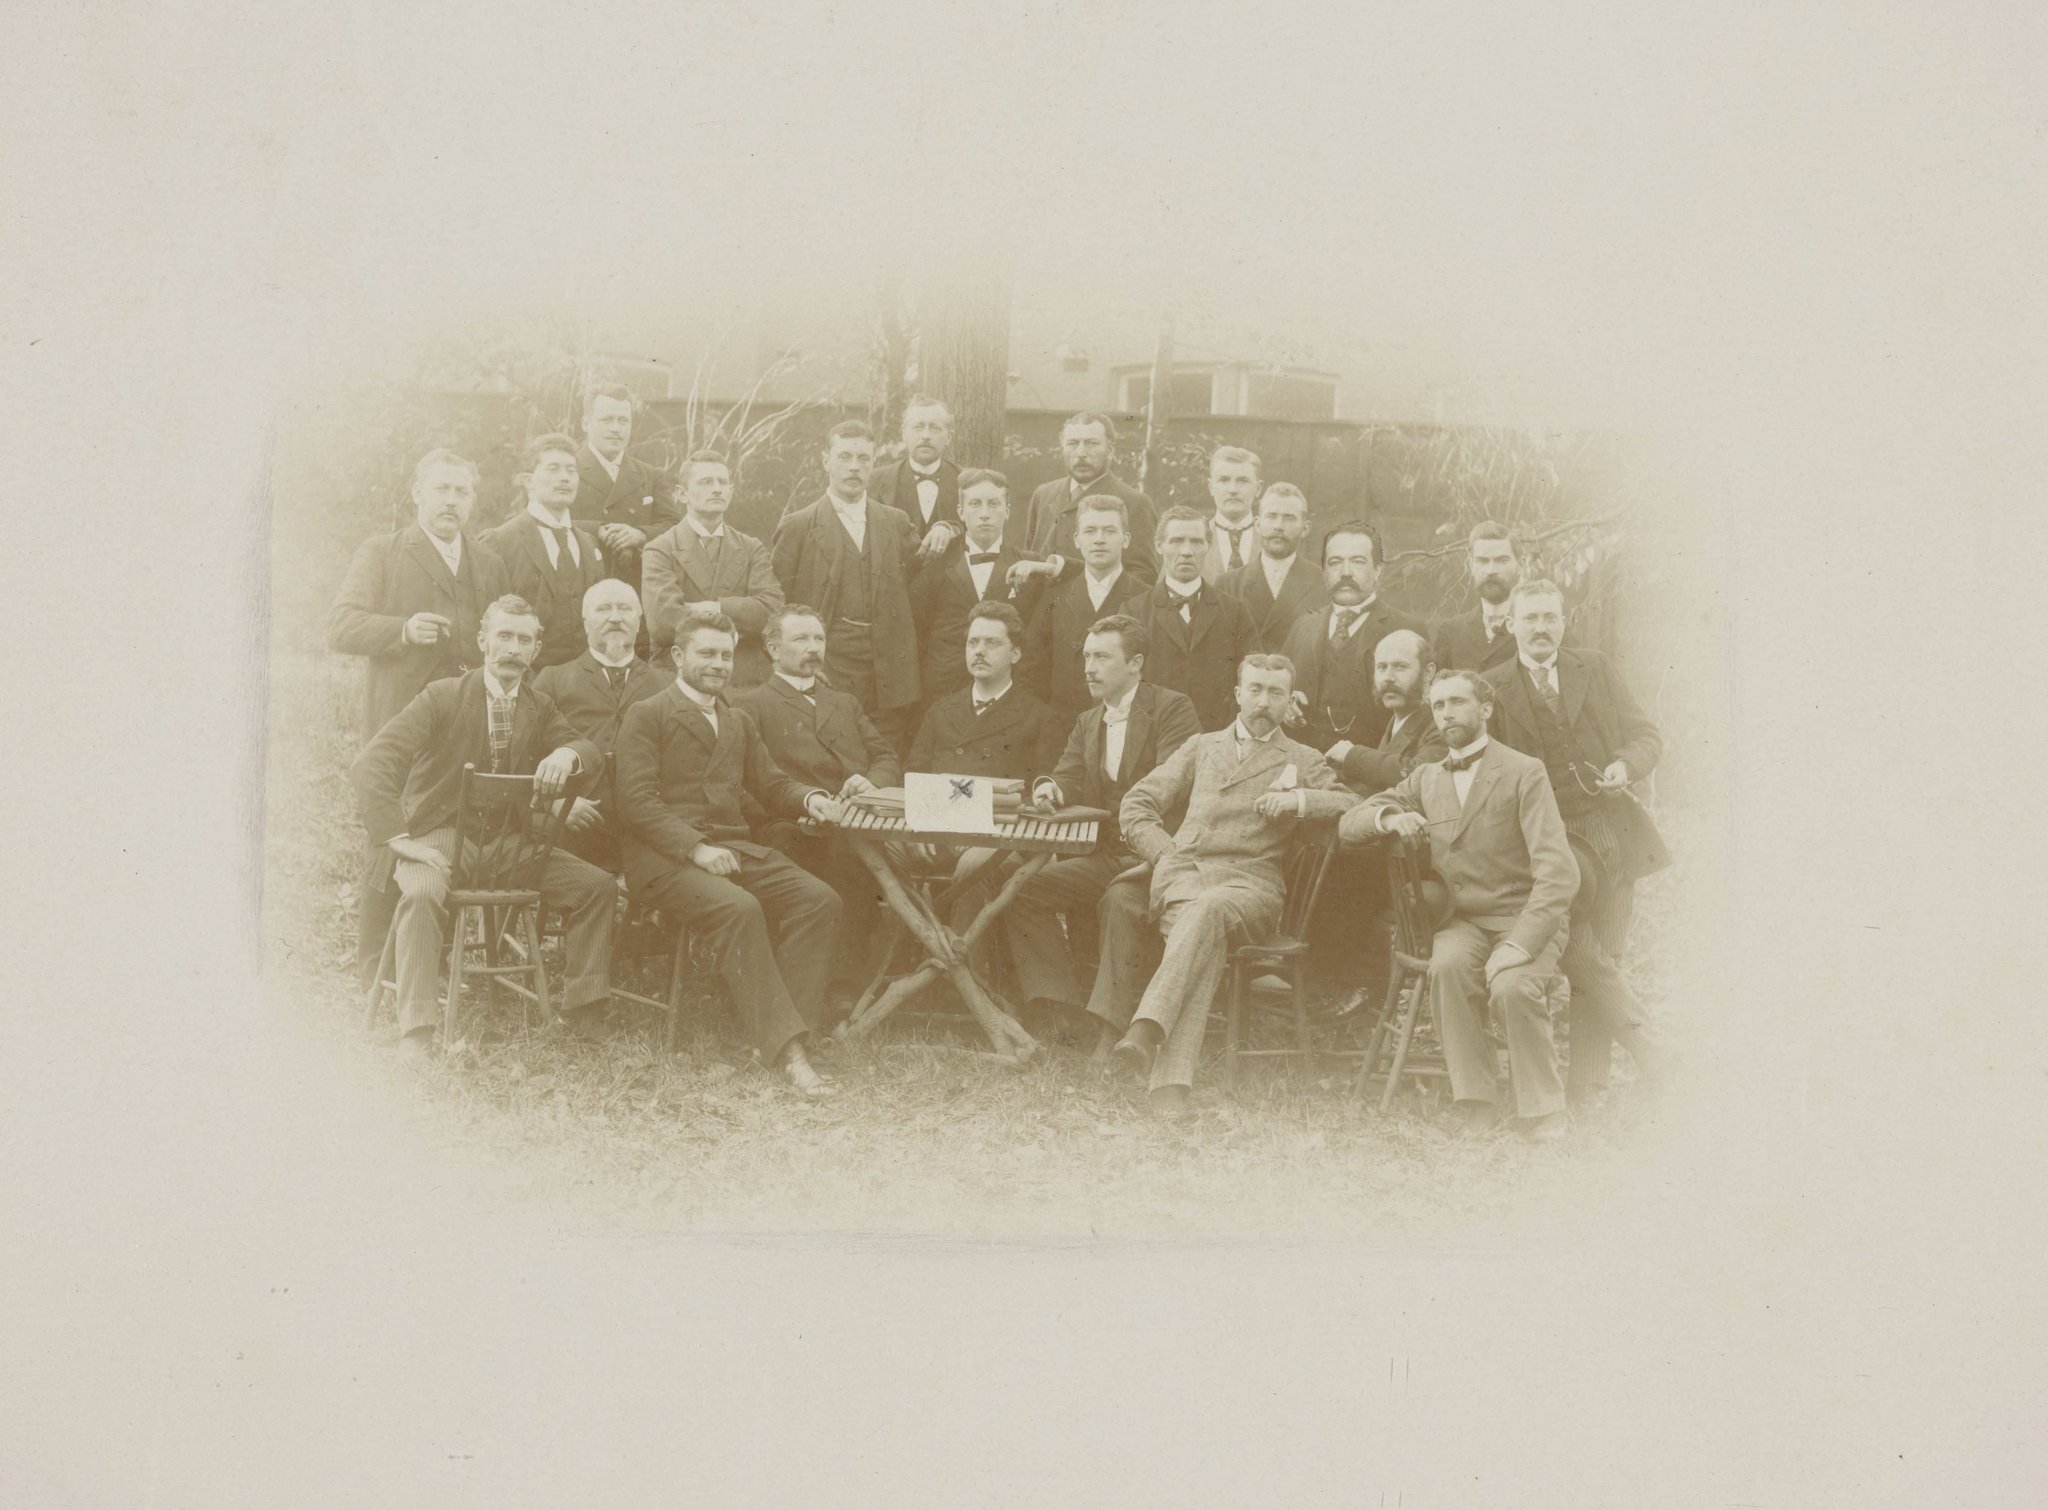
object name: photograph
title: Groepsportret van mannen rond een tafel in een tuin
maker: Anonymous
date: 1910-1930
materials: cardboard, photographic support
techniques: albumen print